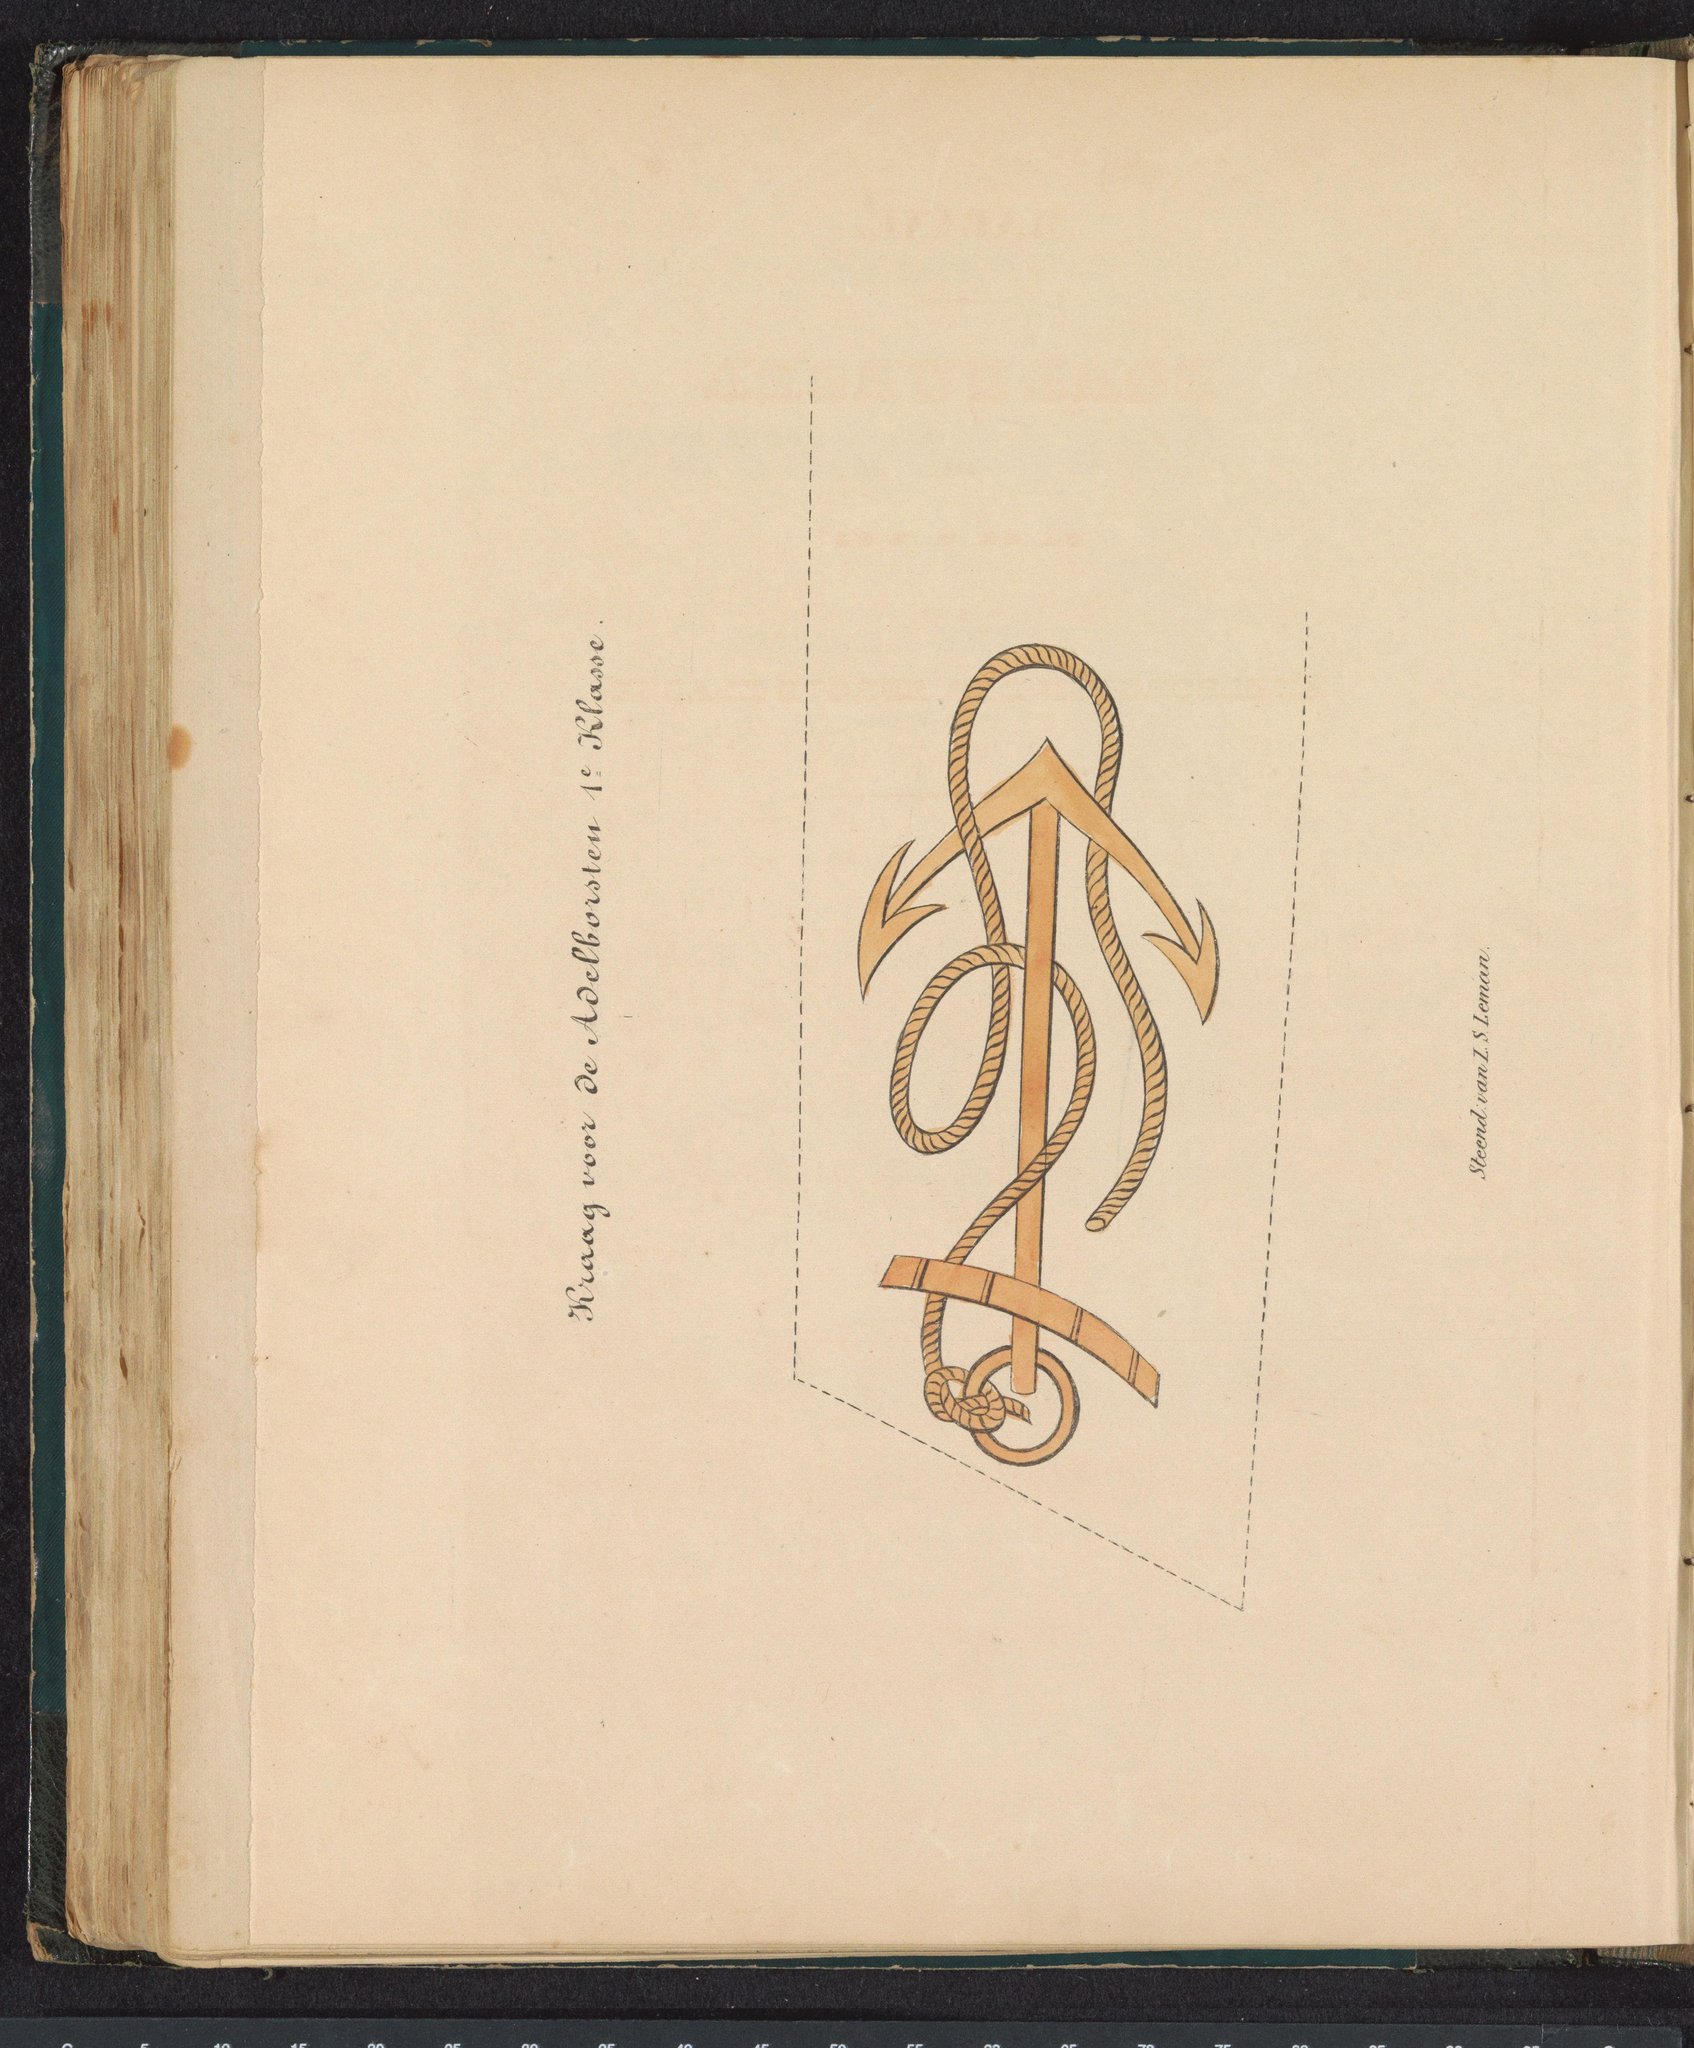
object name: book illustration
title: Borduursel voor het uniform voor adelborsten eerste klasse van de Marine, 1845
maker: louis salomon leman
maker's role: steendrukker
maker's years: 1818-1889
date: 1845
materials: paper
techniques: hand coloring, lithograph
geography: netherlands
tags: (military) uniforms, netherlands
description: Borduursel voor het uniform voor adelborsten eerste klasse van de Marine. Illustratie in een boek uit 1845 over de uniformen en kledingstukken van de Nederlandse land-, zeemacht en schutterijen in Nederland en in de overzeese gebiedsdelen.